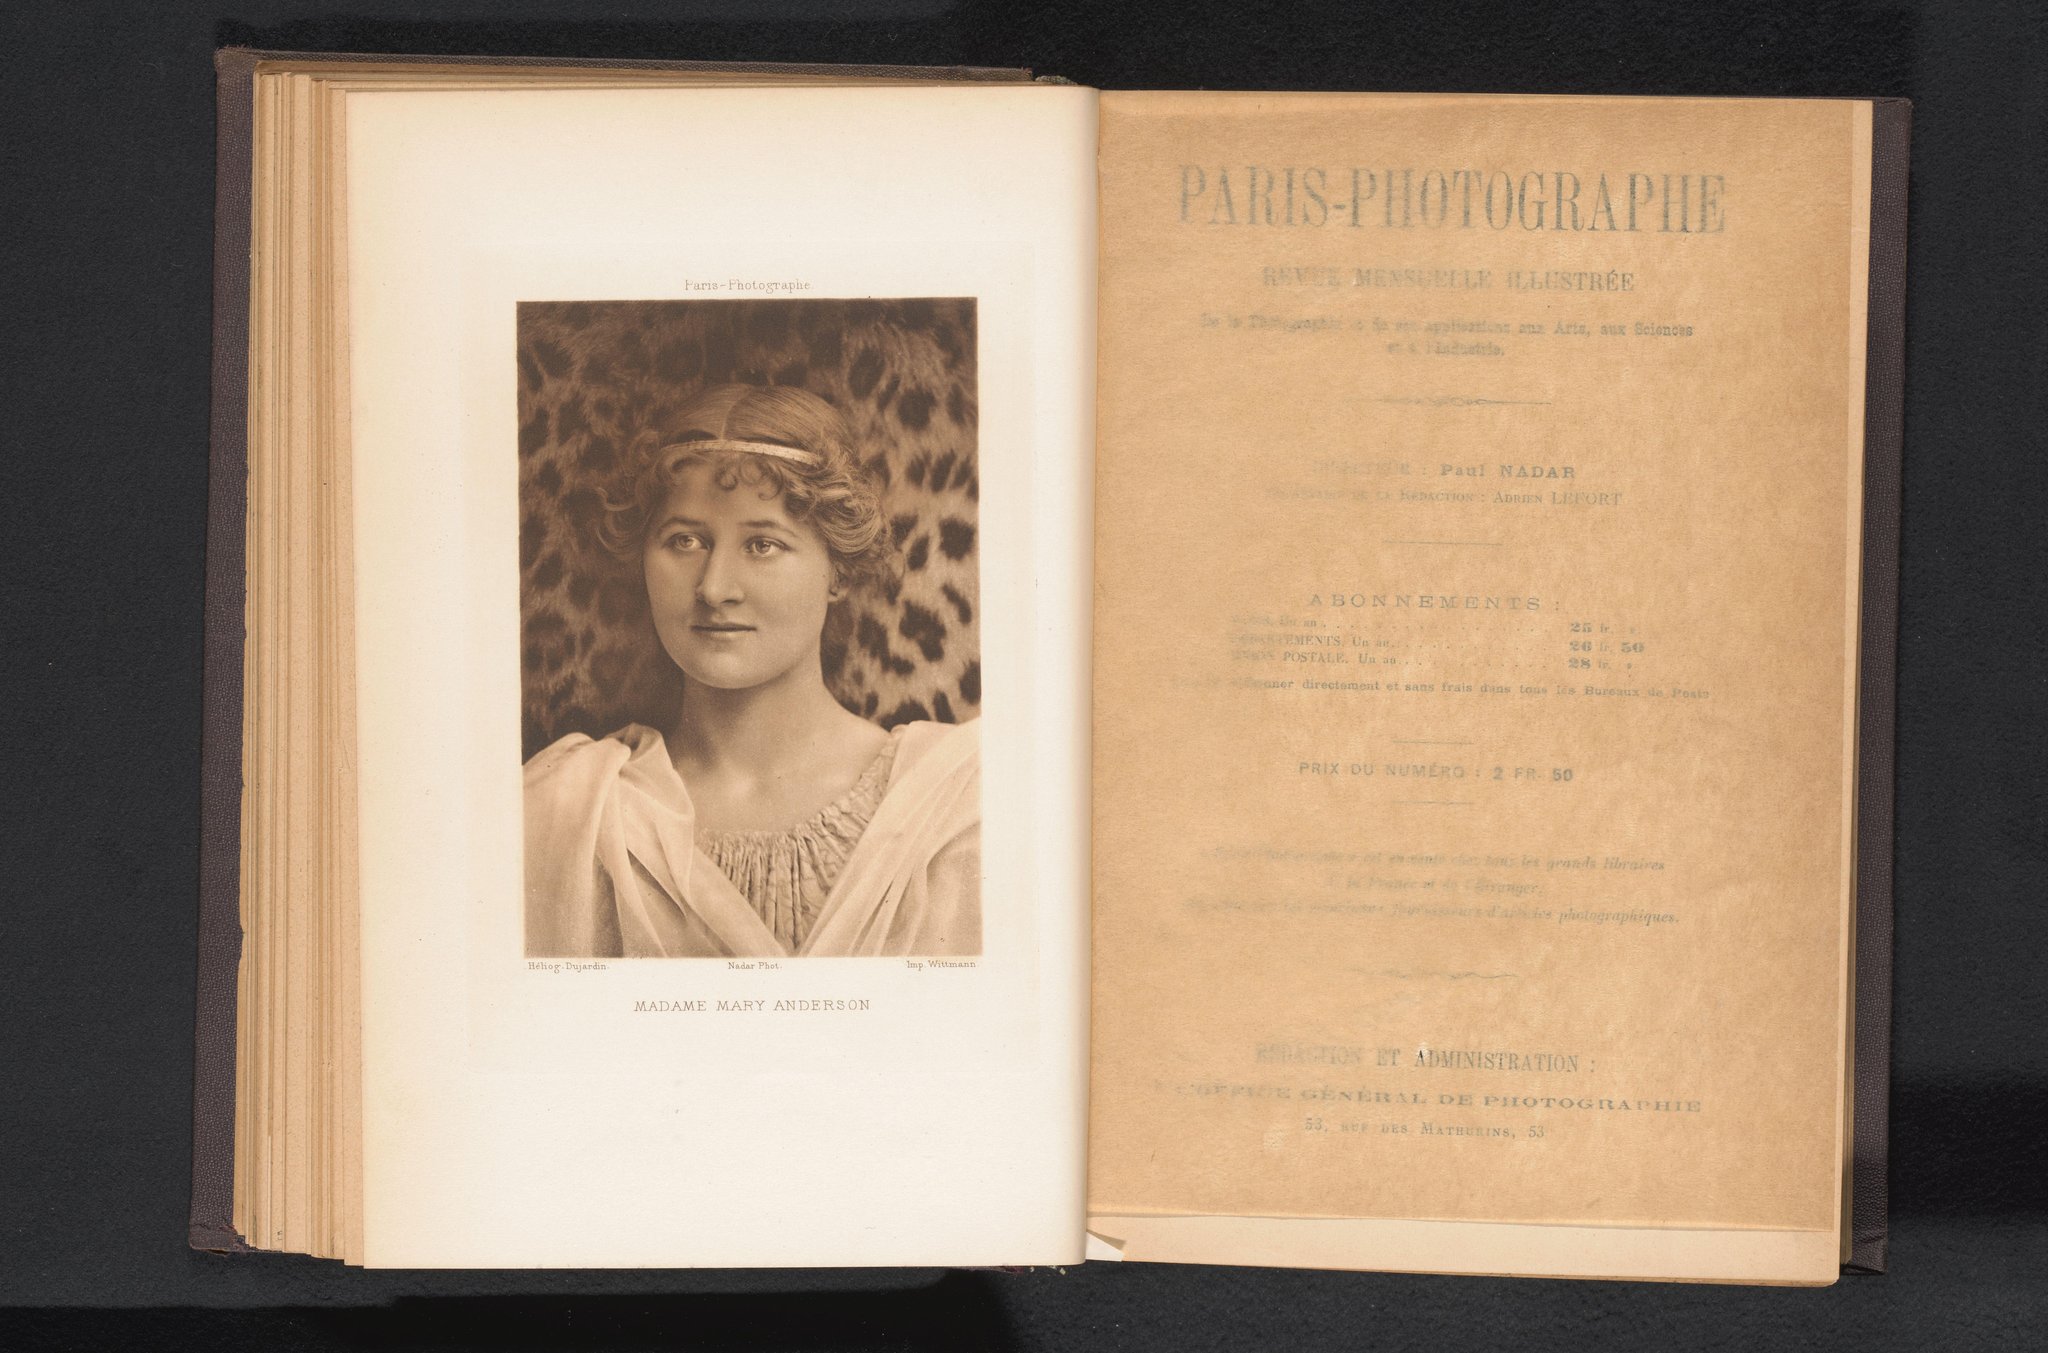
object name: photomechanical print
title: Portret van Mary Anderson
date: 1883-1893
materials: paper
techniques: photoaquatint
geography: france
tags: portrait of actor, actress